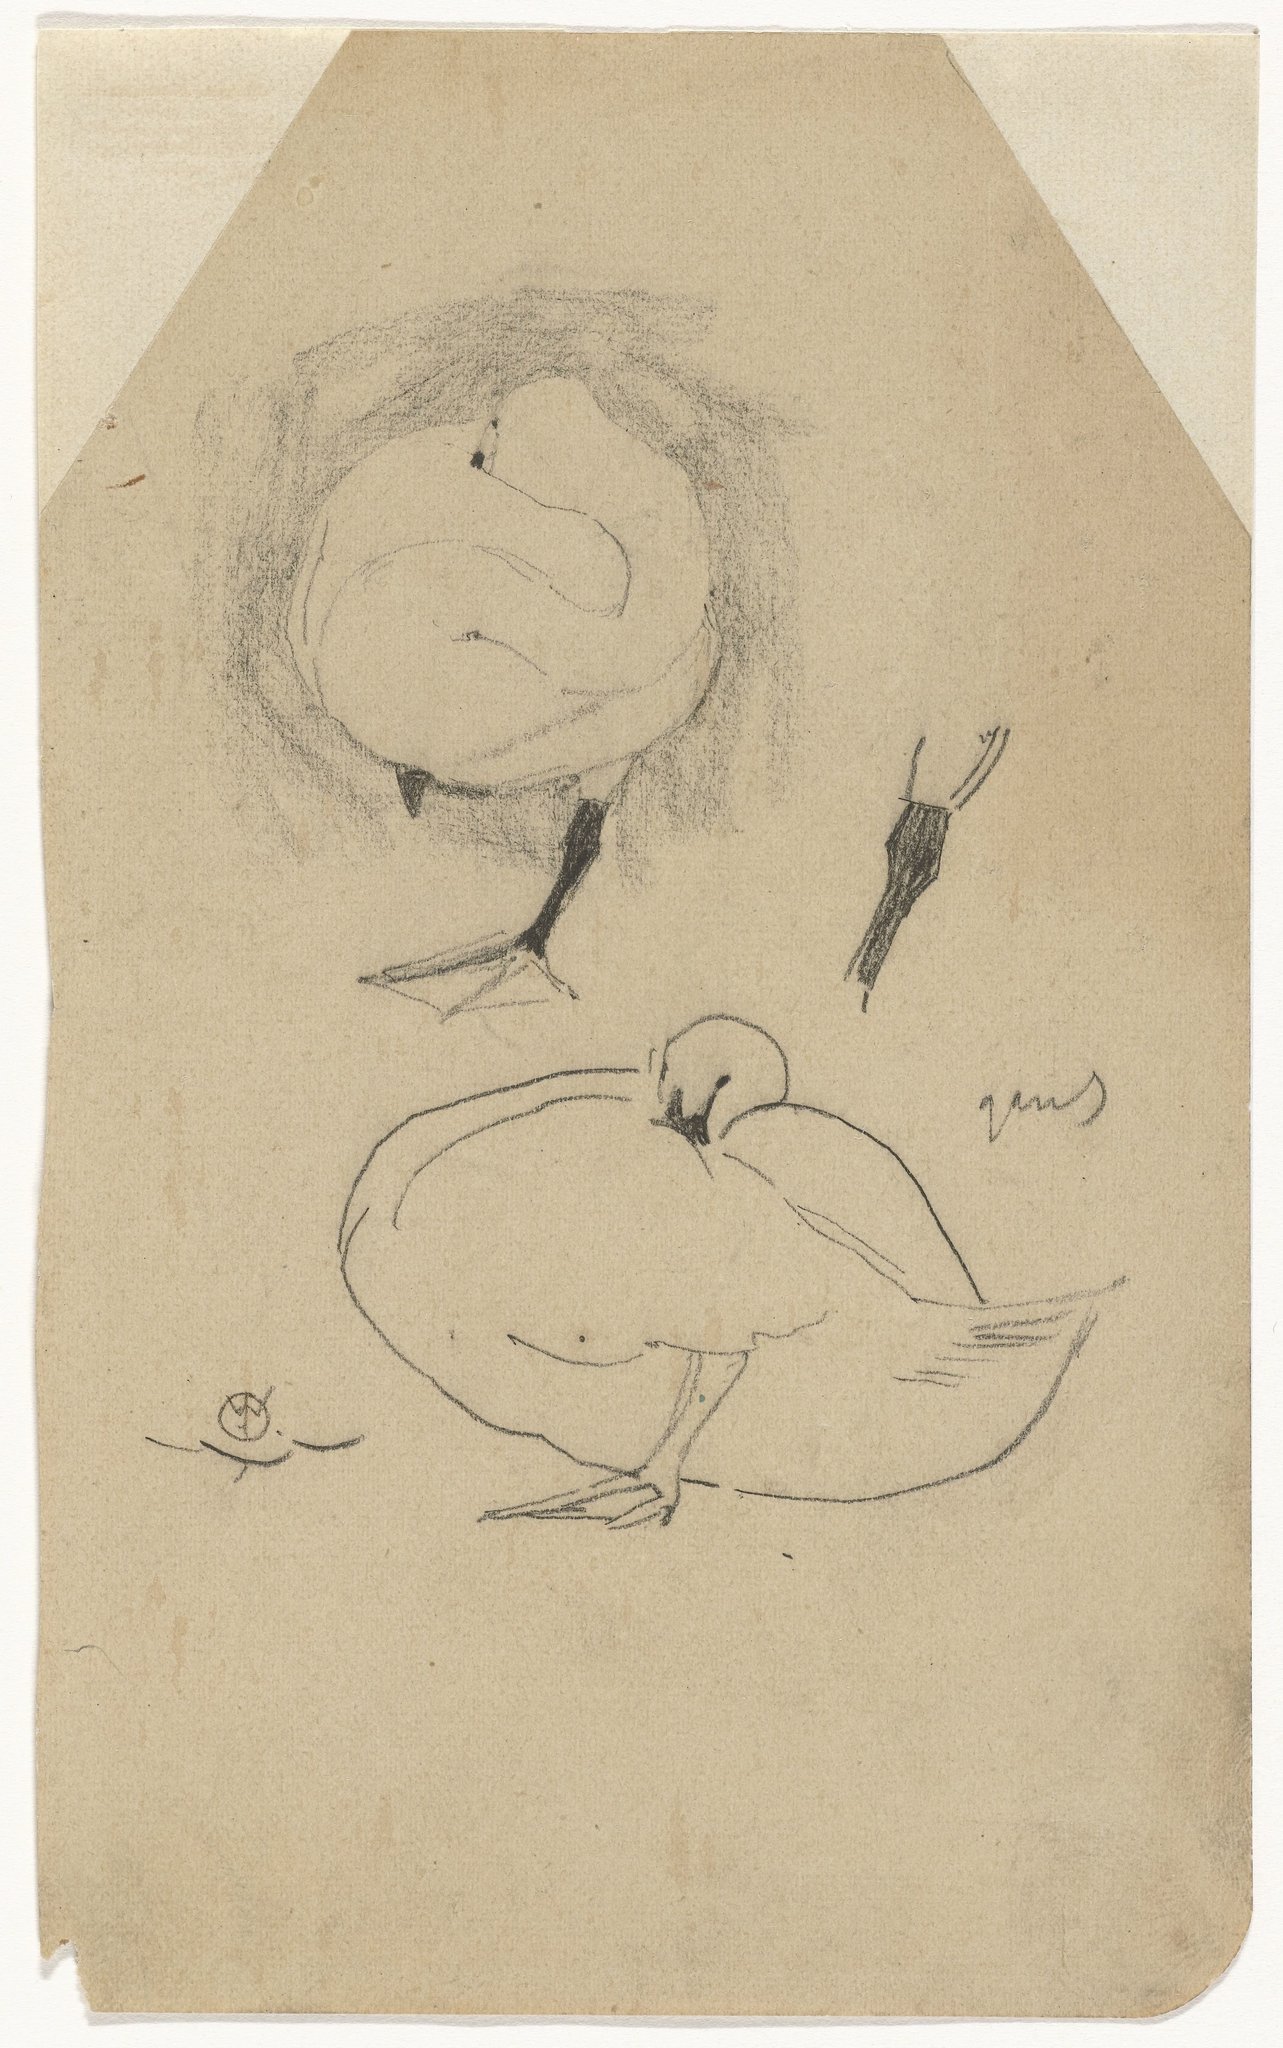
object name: drawing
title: Gans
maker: gerrit willem dijsselhof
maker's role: designer, draughtsman, print maker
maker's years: 1866-1924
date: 1876-1924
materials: chalk, paper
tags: geese (domestic waterbirds)